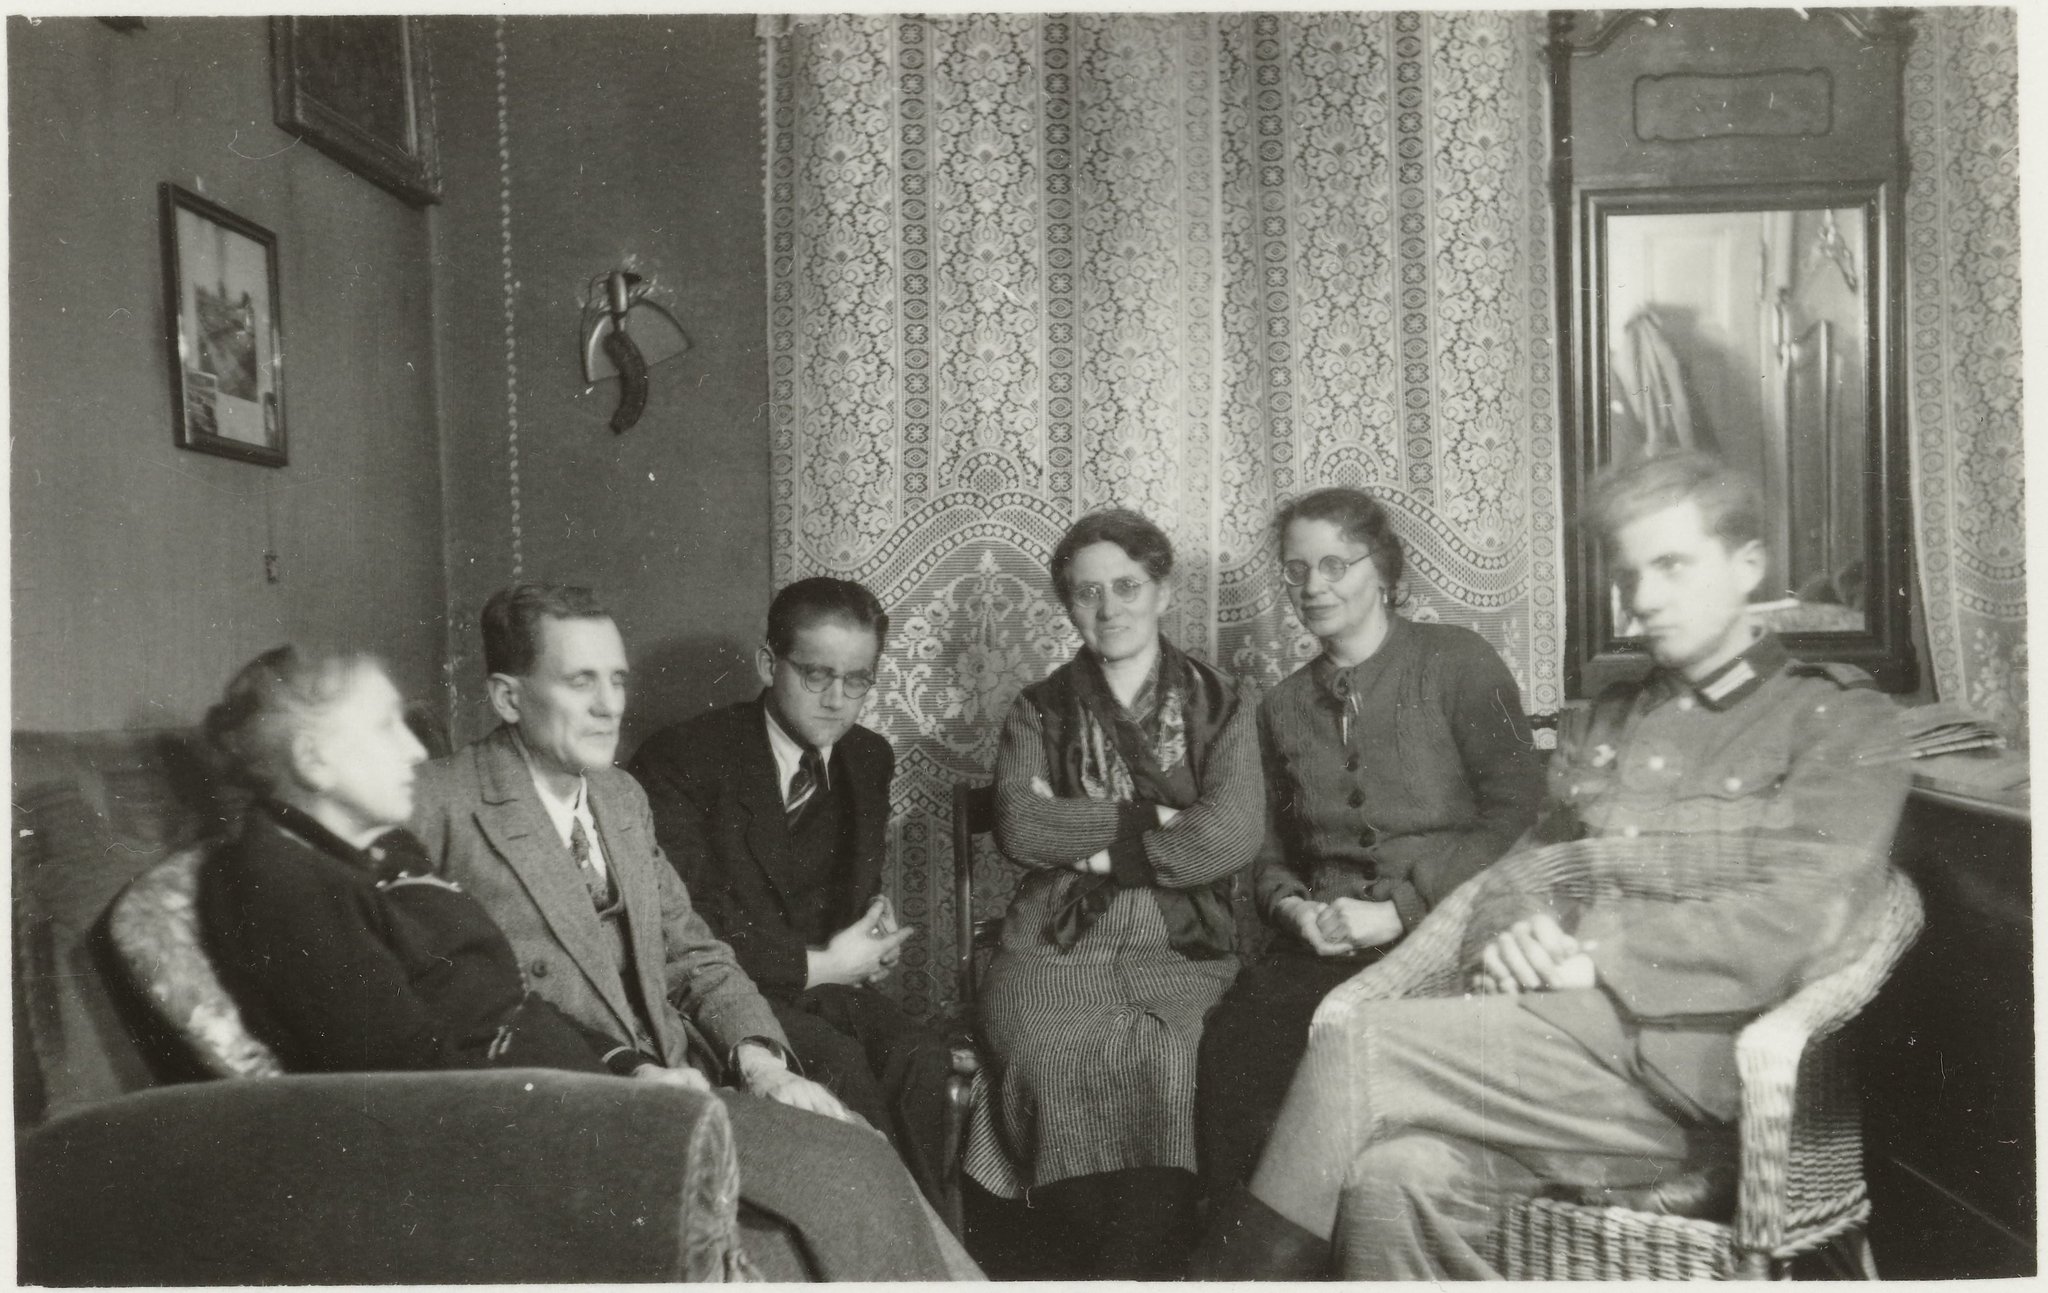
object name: photograph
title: Mensen in een kamer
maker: Anonymous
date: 1940-1945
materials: photographic support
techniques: gelatin silver print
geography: czechoslovakia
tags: netherlands, germany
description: Zeven personen zitten bij elkaar in een kamer, een van hen is in uniform. Achterop staat 1939. Foto behorend bij album 'Kriegserinnerungen'.